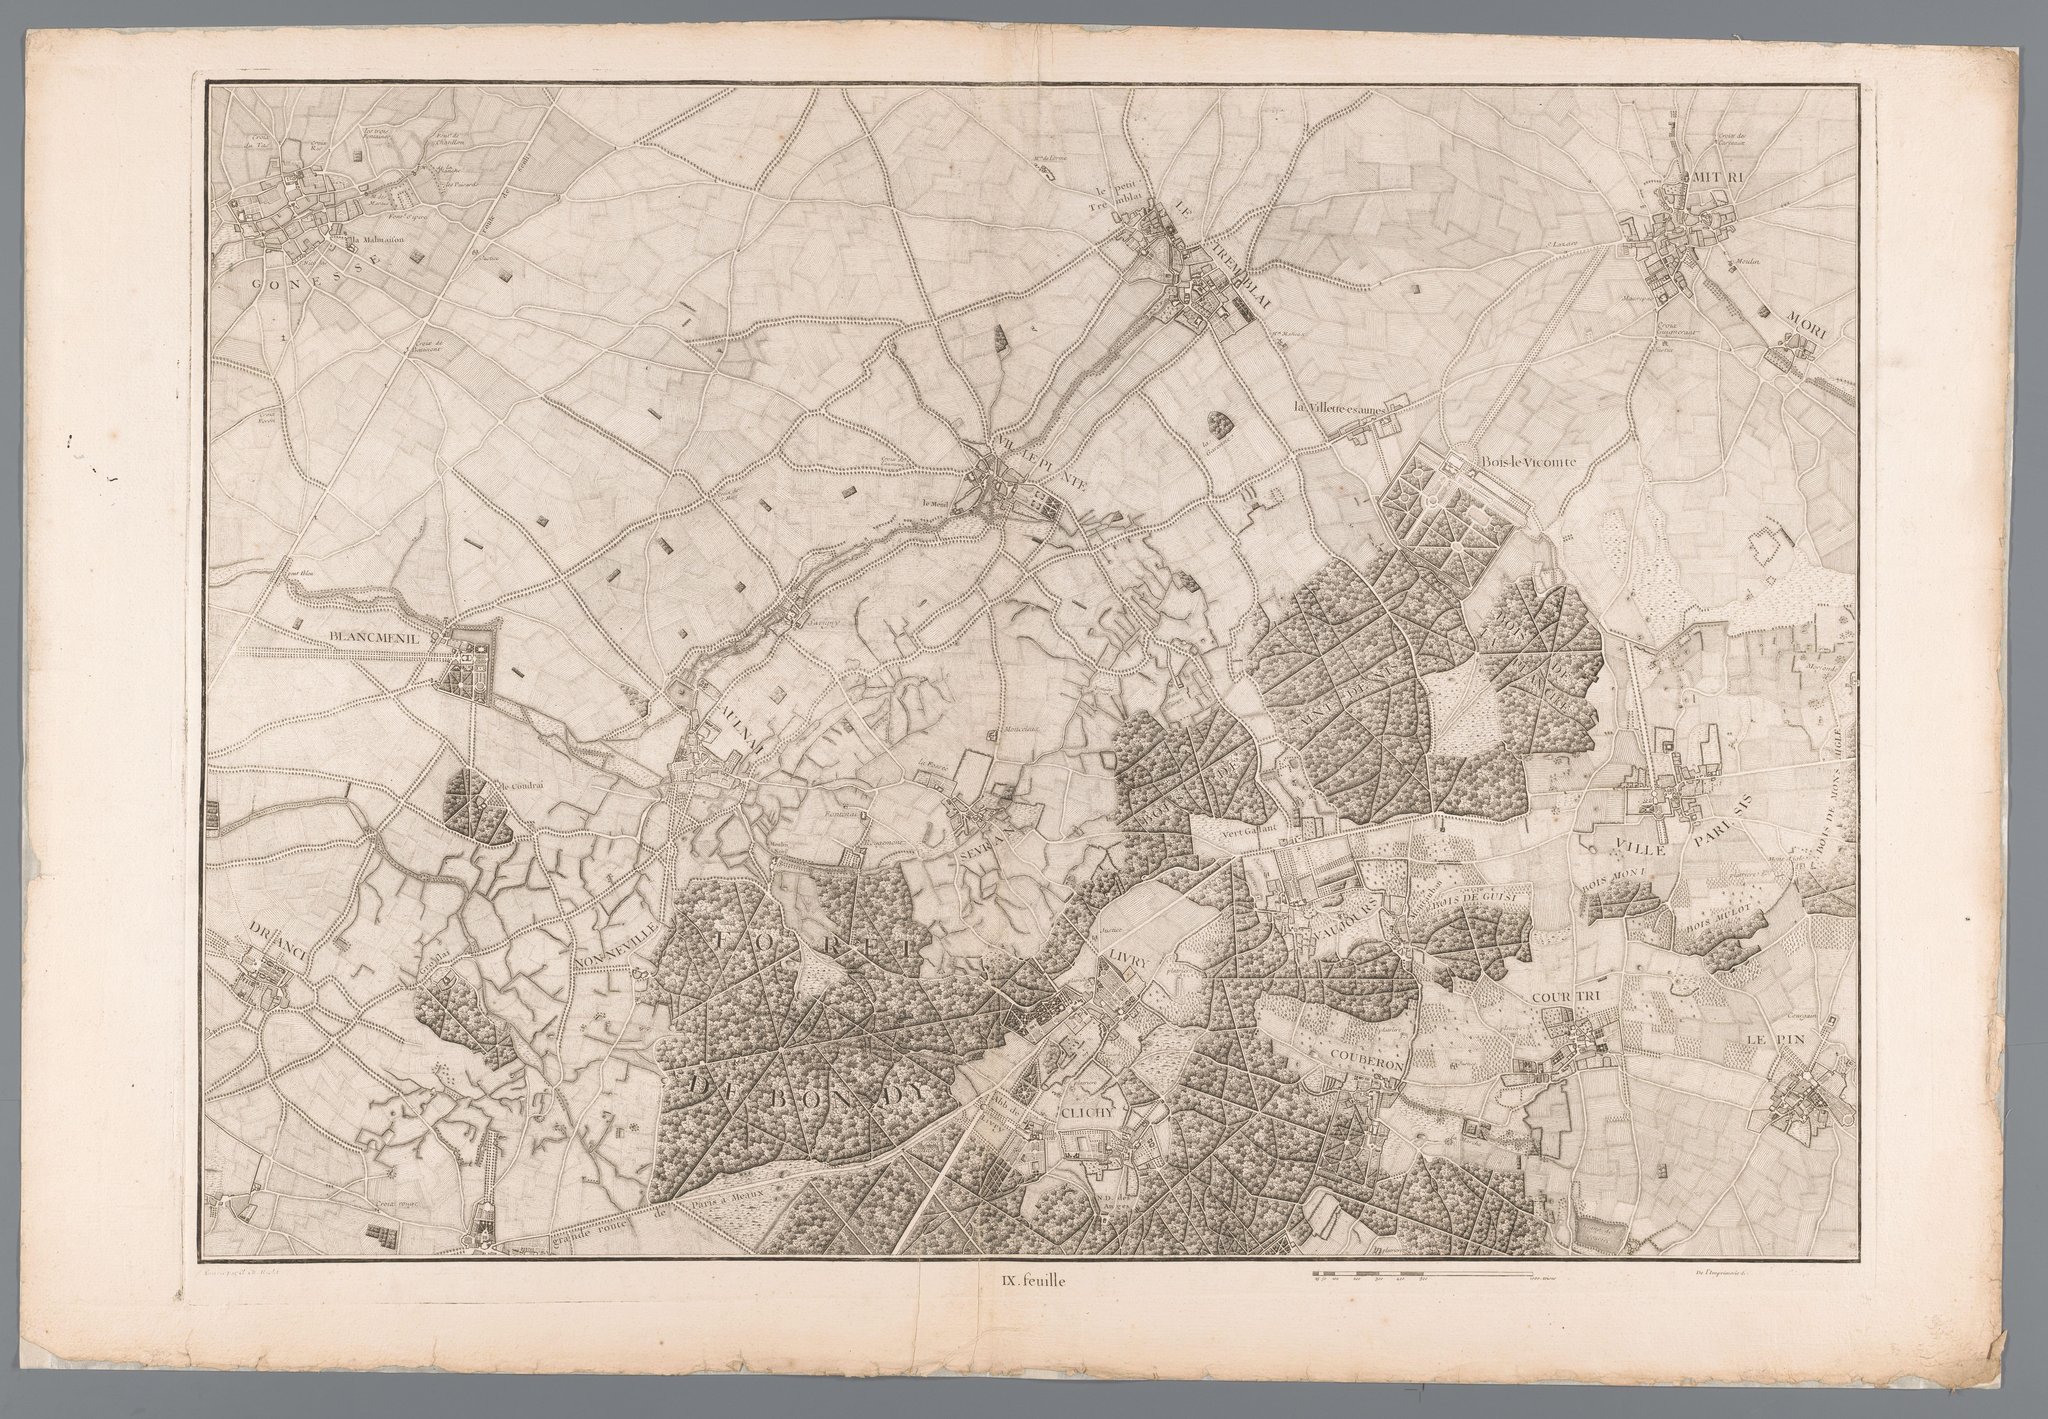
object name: map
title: IX feuille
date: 1740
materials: paper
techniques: engraving, etching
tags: plan, map of garden, maps of cities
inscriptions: collector's mark: Lugt 2228, collector's mark: Lugt 2760